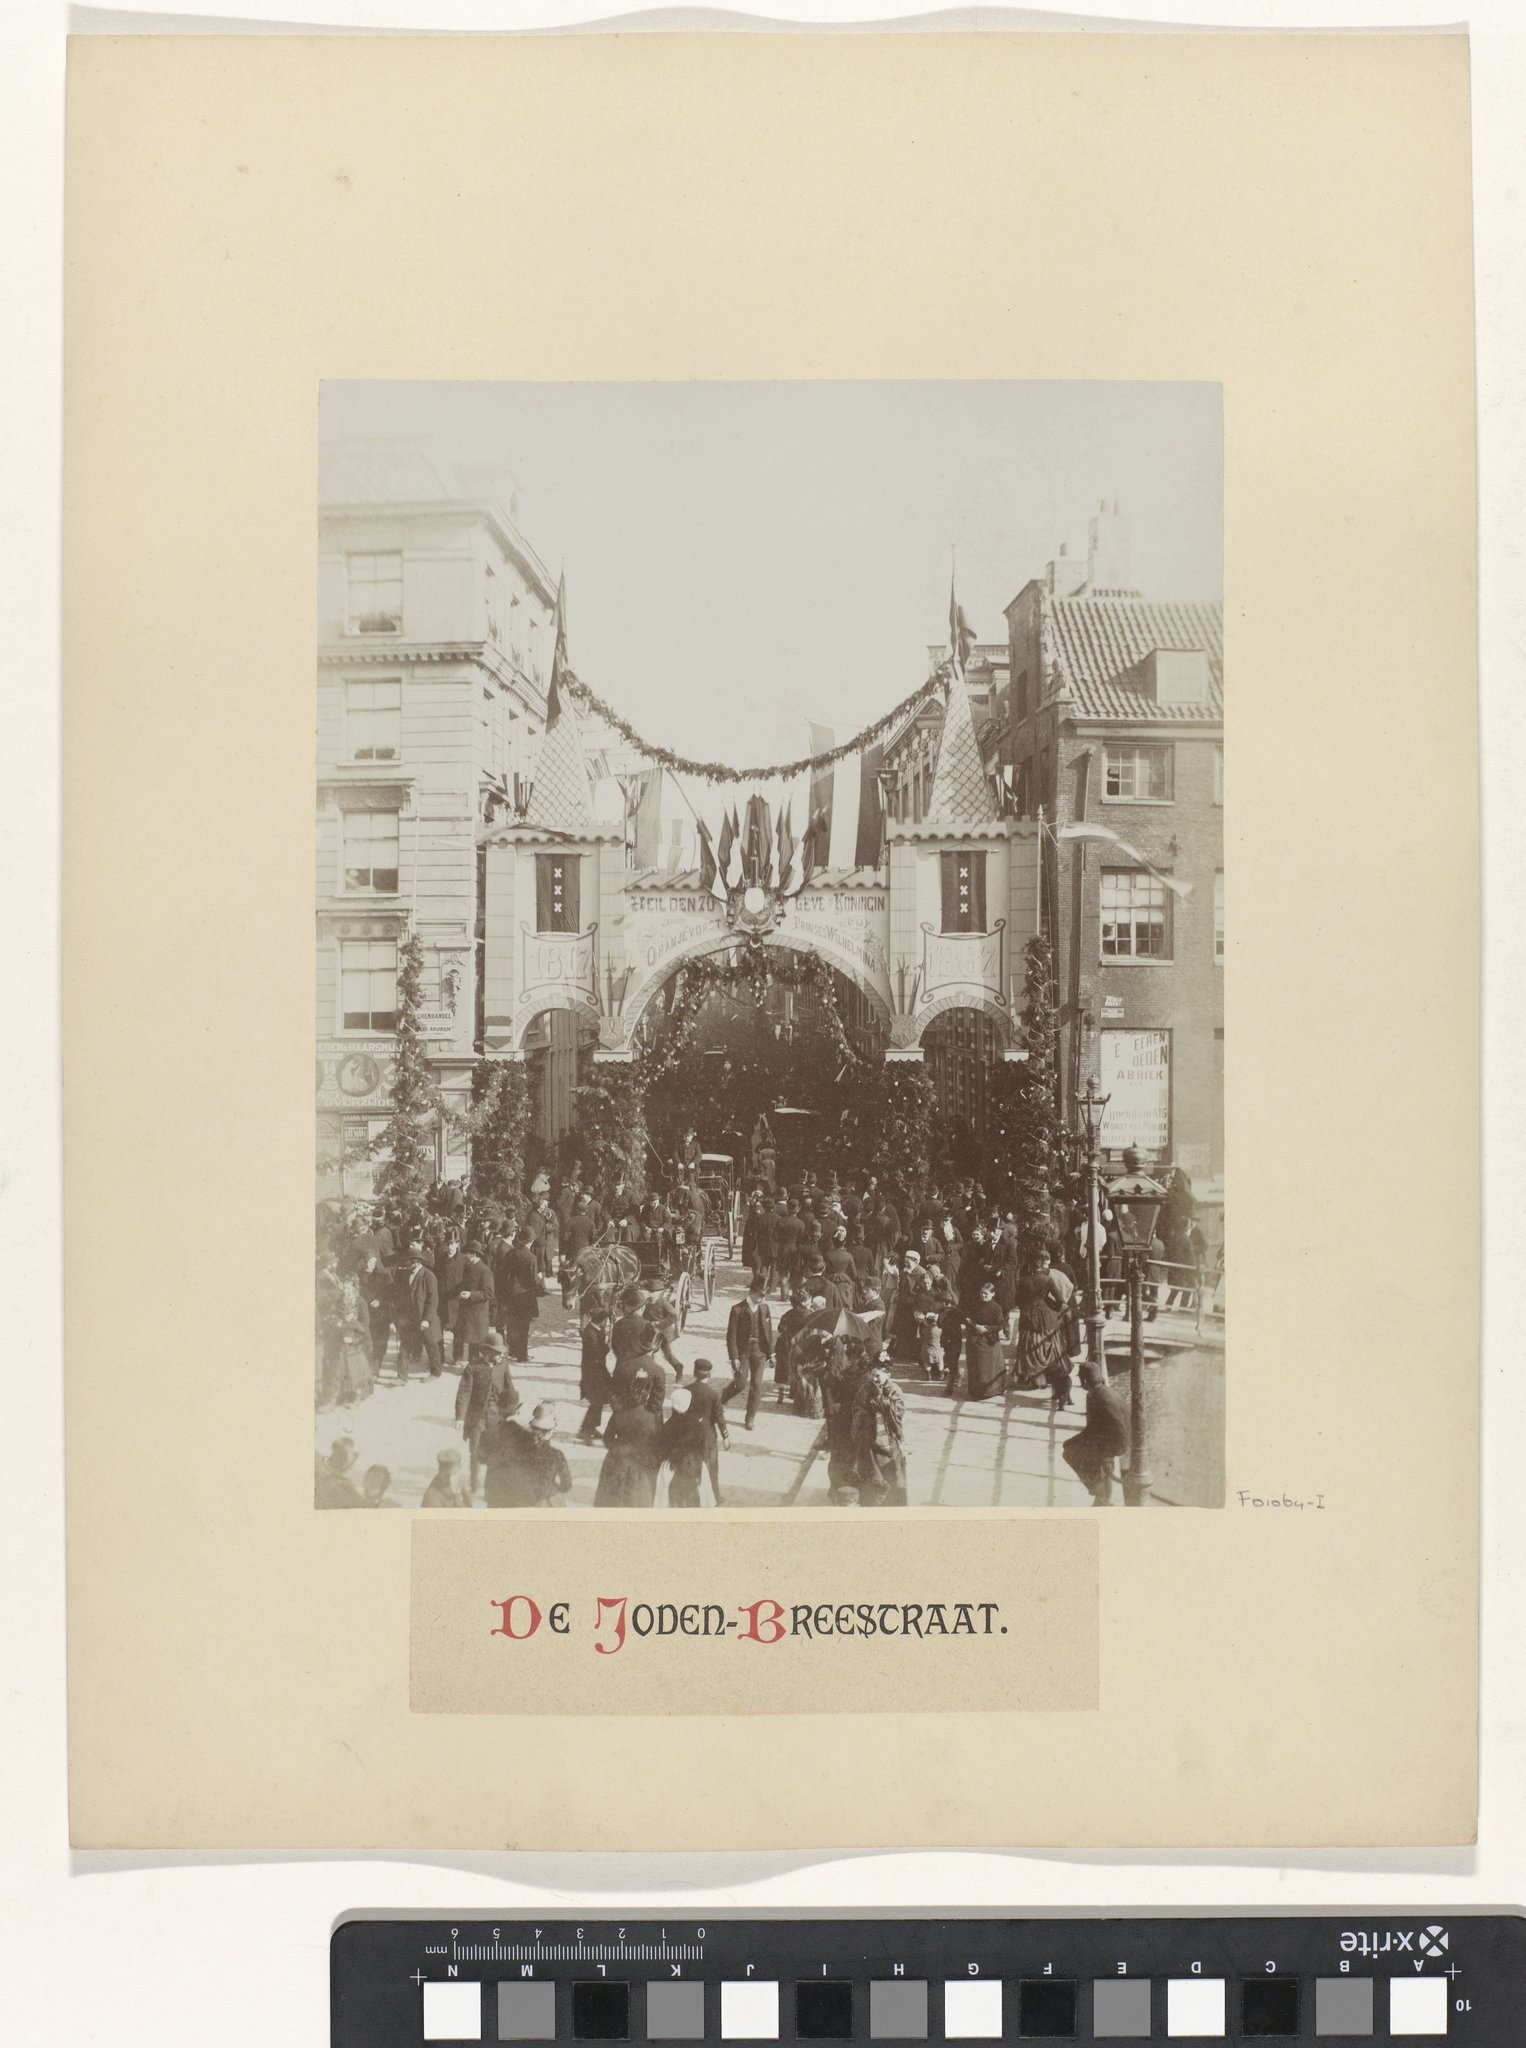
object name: photograph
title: Ereboog in de Jodenbreestraat tijdens de Aprilfeesten in 1887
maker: henri de louw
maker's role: fotograaf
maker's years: 1851-1944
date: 1887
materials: cardboard, paper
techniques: albumen print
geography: amsterdam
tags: public festivities on the occasion of royal events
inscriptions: inscription: ‘De Joden-Breestraat’, watermark: ‘K. Rives No 34’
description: Deze foto maakt deel uit van een omslag met twaalf foto's.